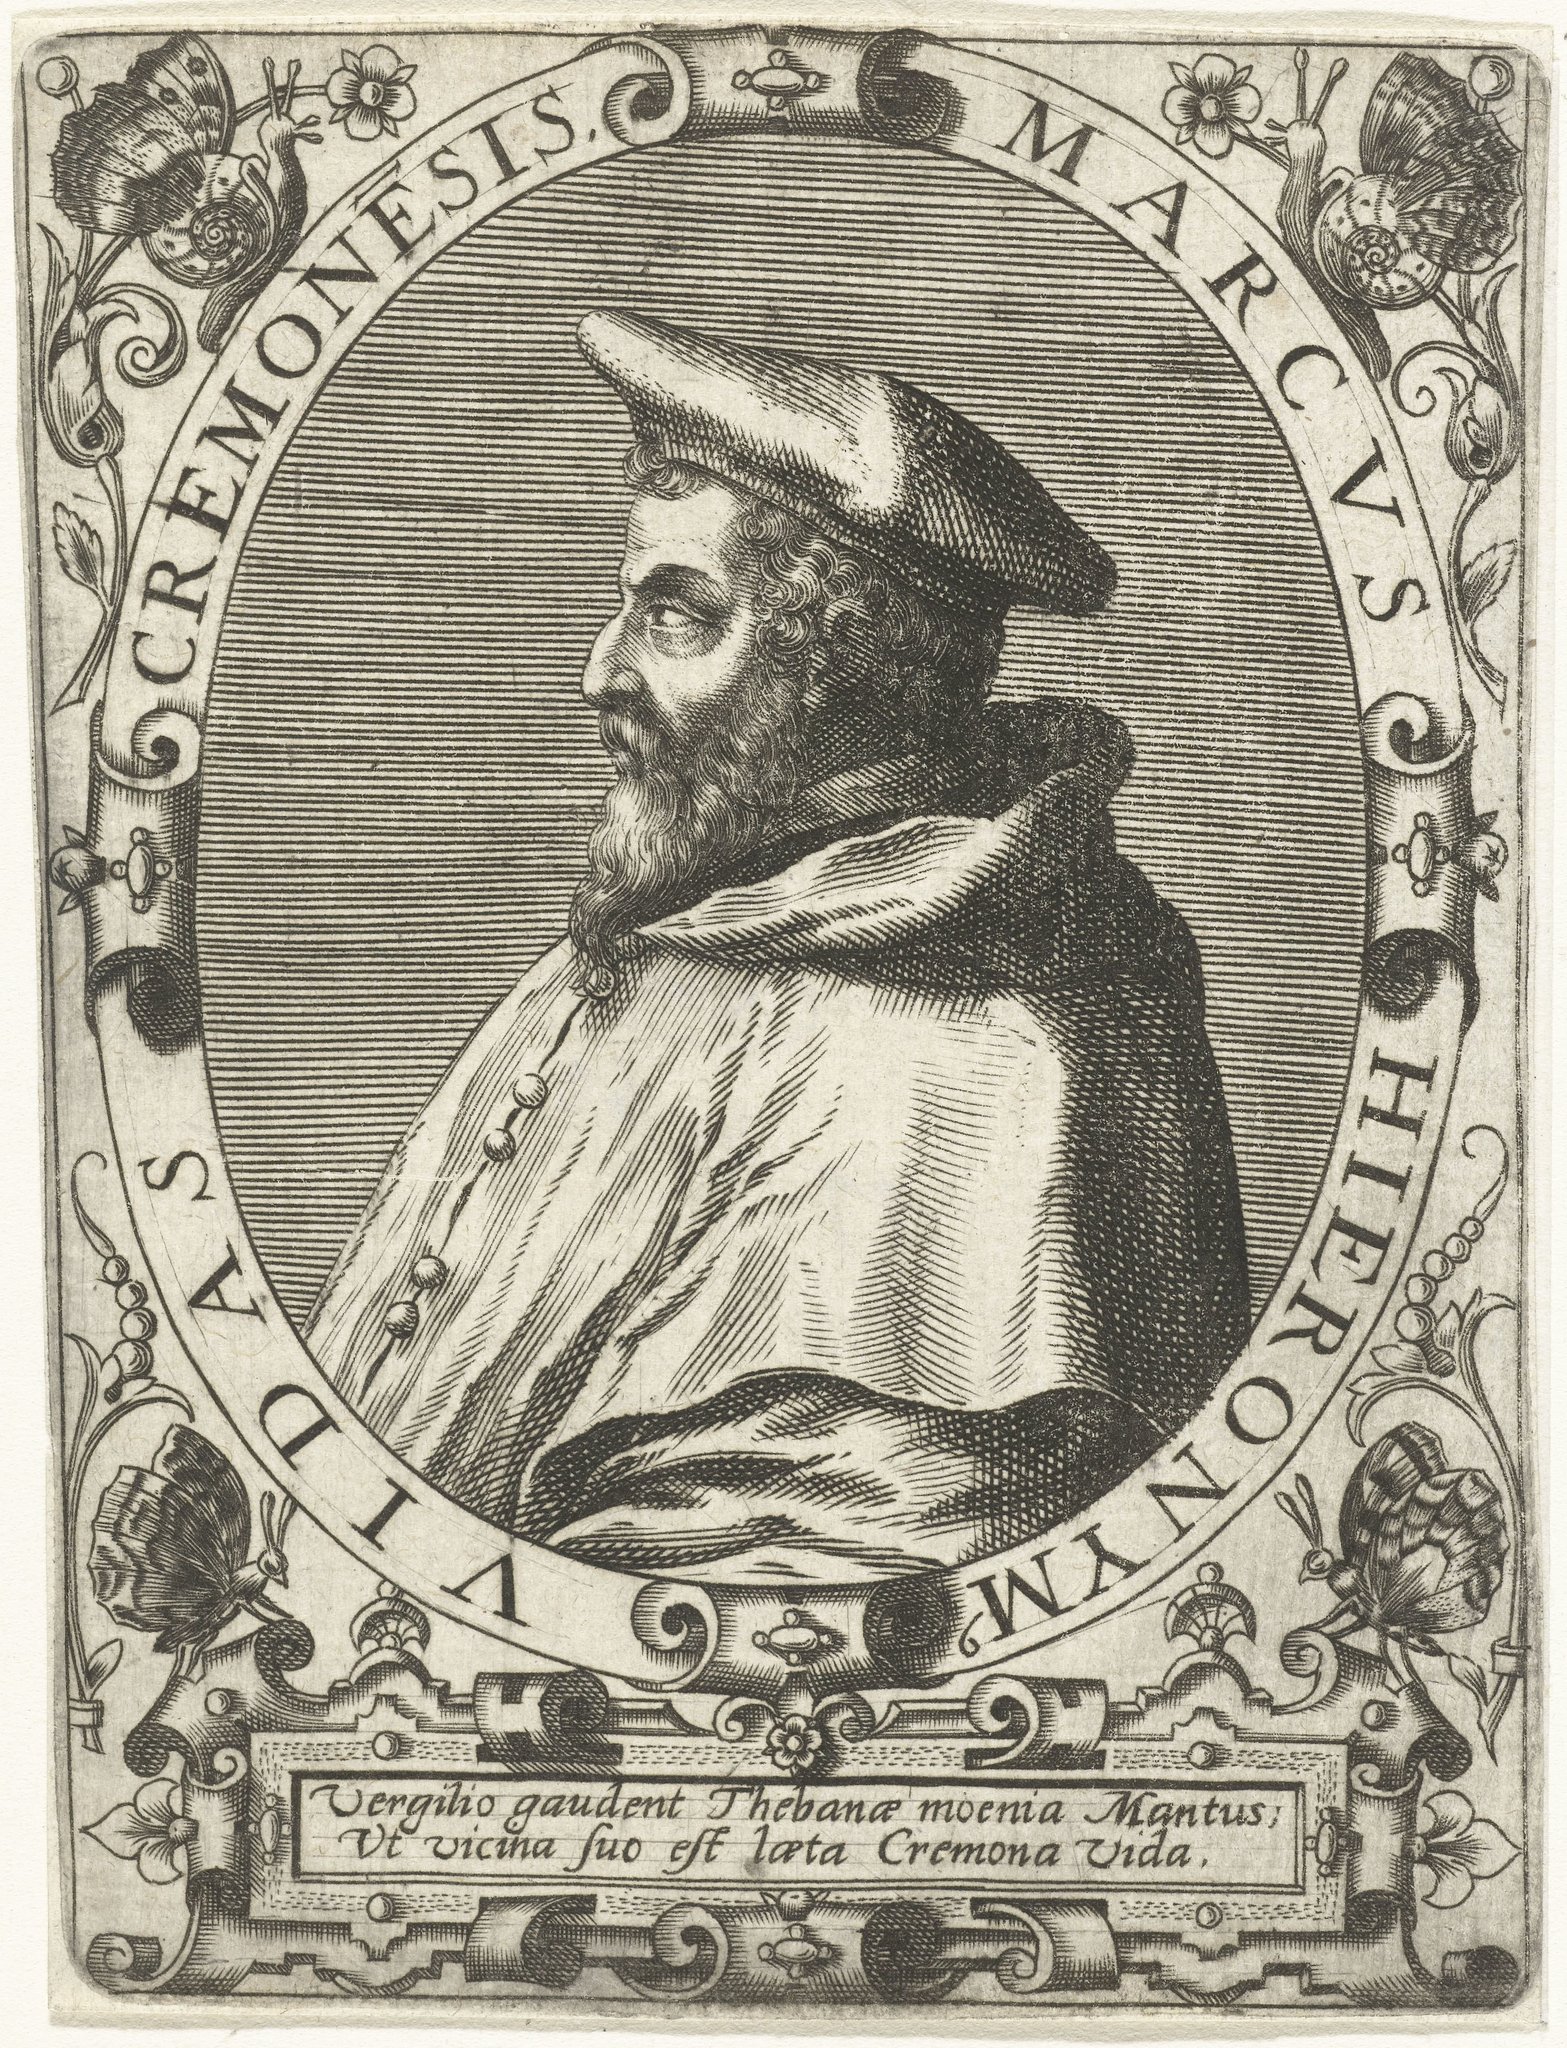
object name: print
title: Marcus Hieronymus Vidas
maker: jean jacques boissard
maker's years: 1528-1598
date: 1597-1599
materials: paper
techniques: engraving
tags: cremona, dichter, bisschop, humanist, marco girolamo vida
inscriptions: collector's mark: Lugt 2228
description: Gemaakt voor: J.J. Boissard, Icones virorum illustrium doctrina &c eruditione praestanti um contines. Frankfurt am Main: de Bry, 1597-1599.